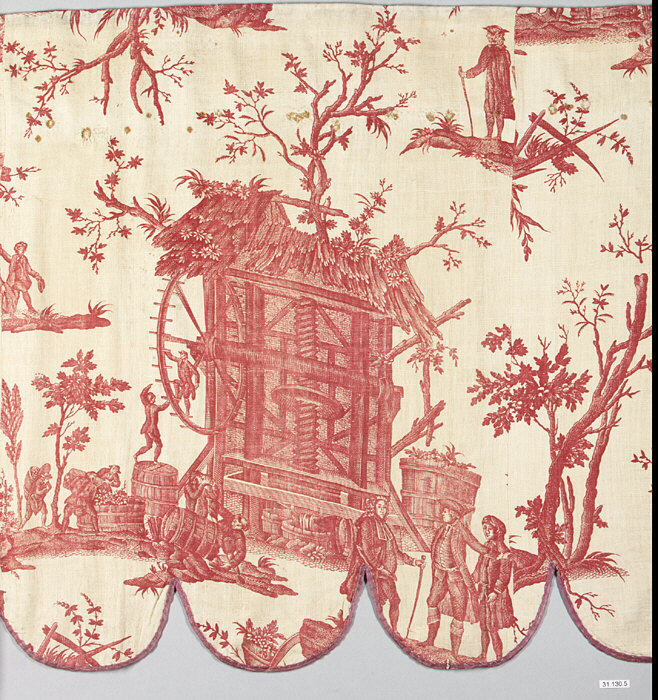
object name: furnishing textile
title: "La Maison Brulante"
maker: petitpierre et cie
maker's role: manufactory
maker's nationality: french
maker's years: 1790-1802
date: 1701-1800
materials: cotton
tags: men,industry